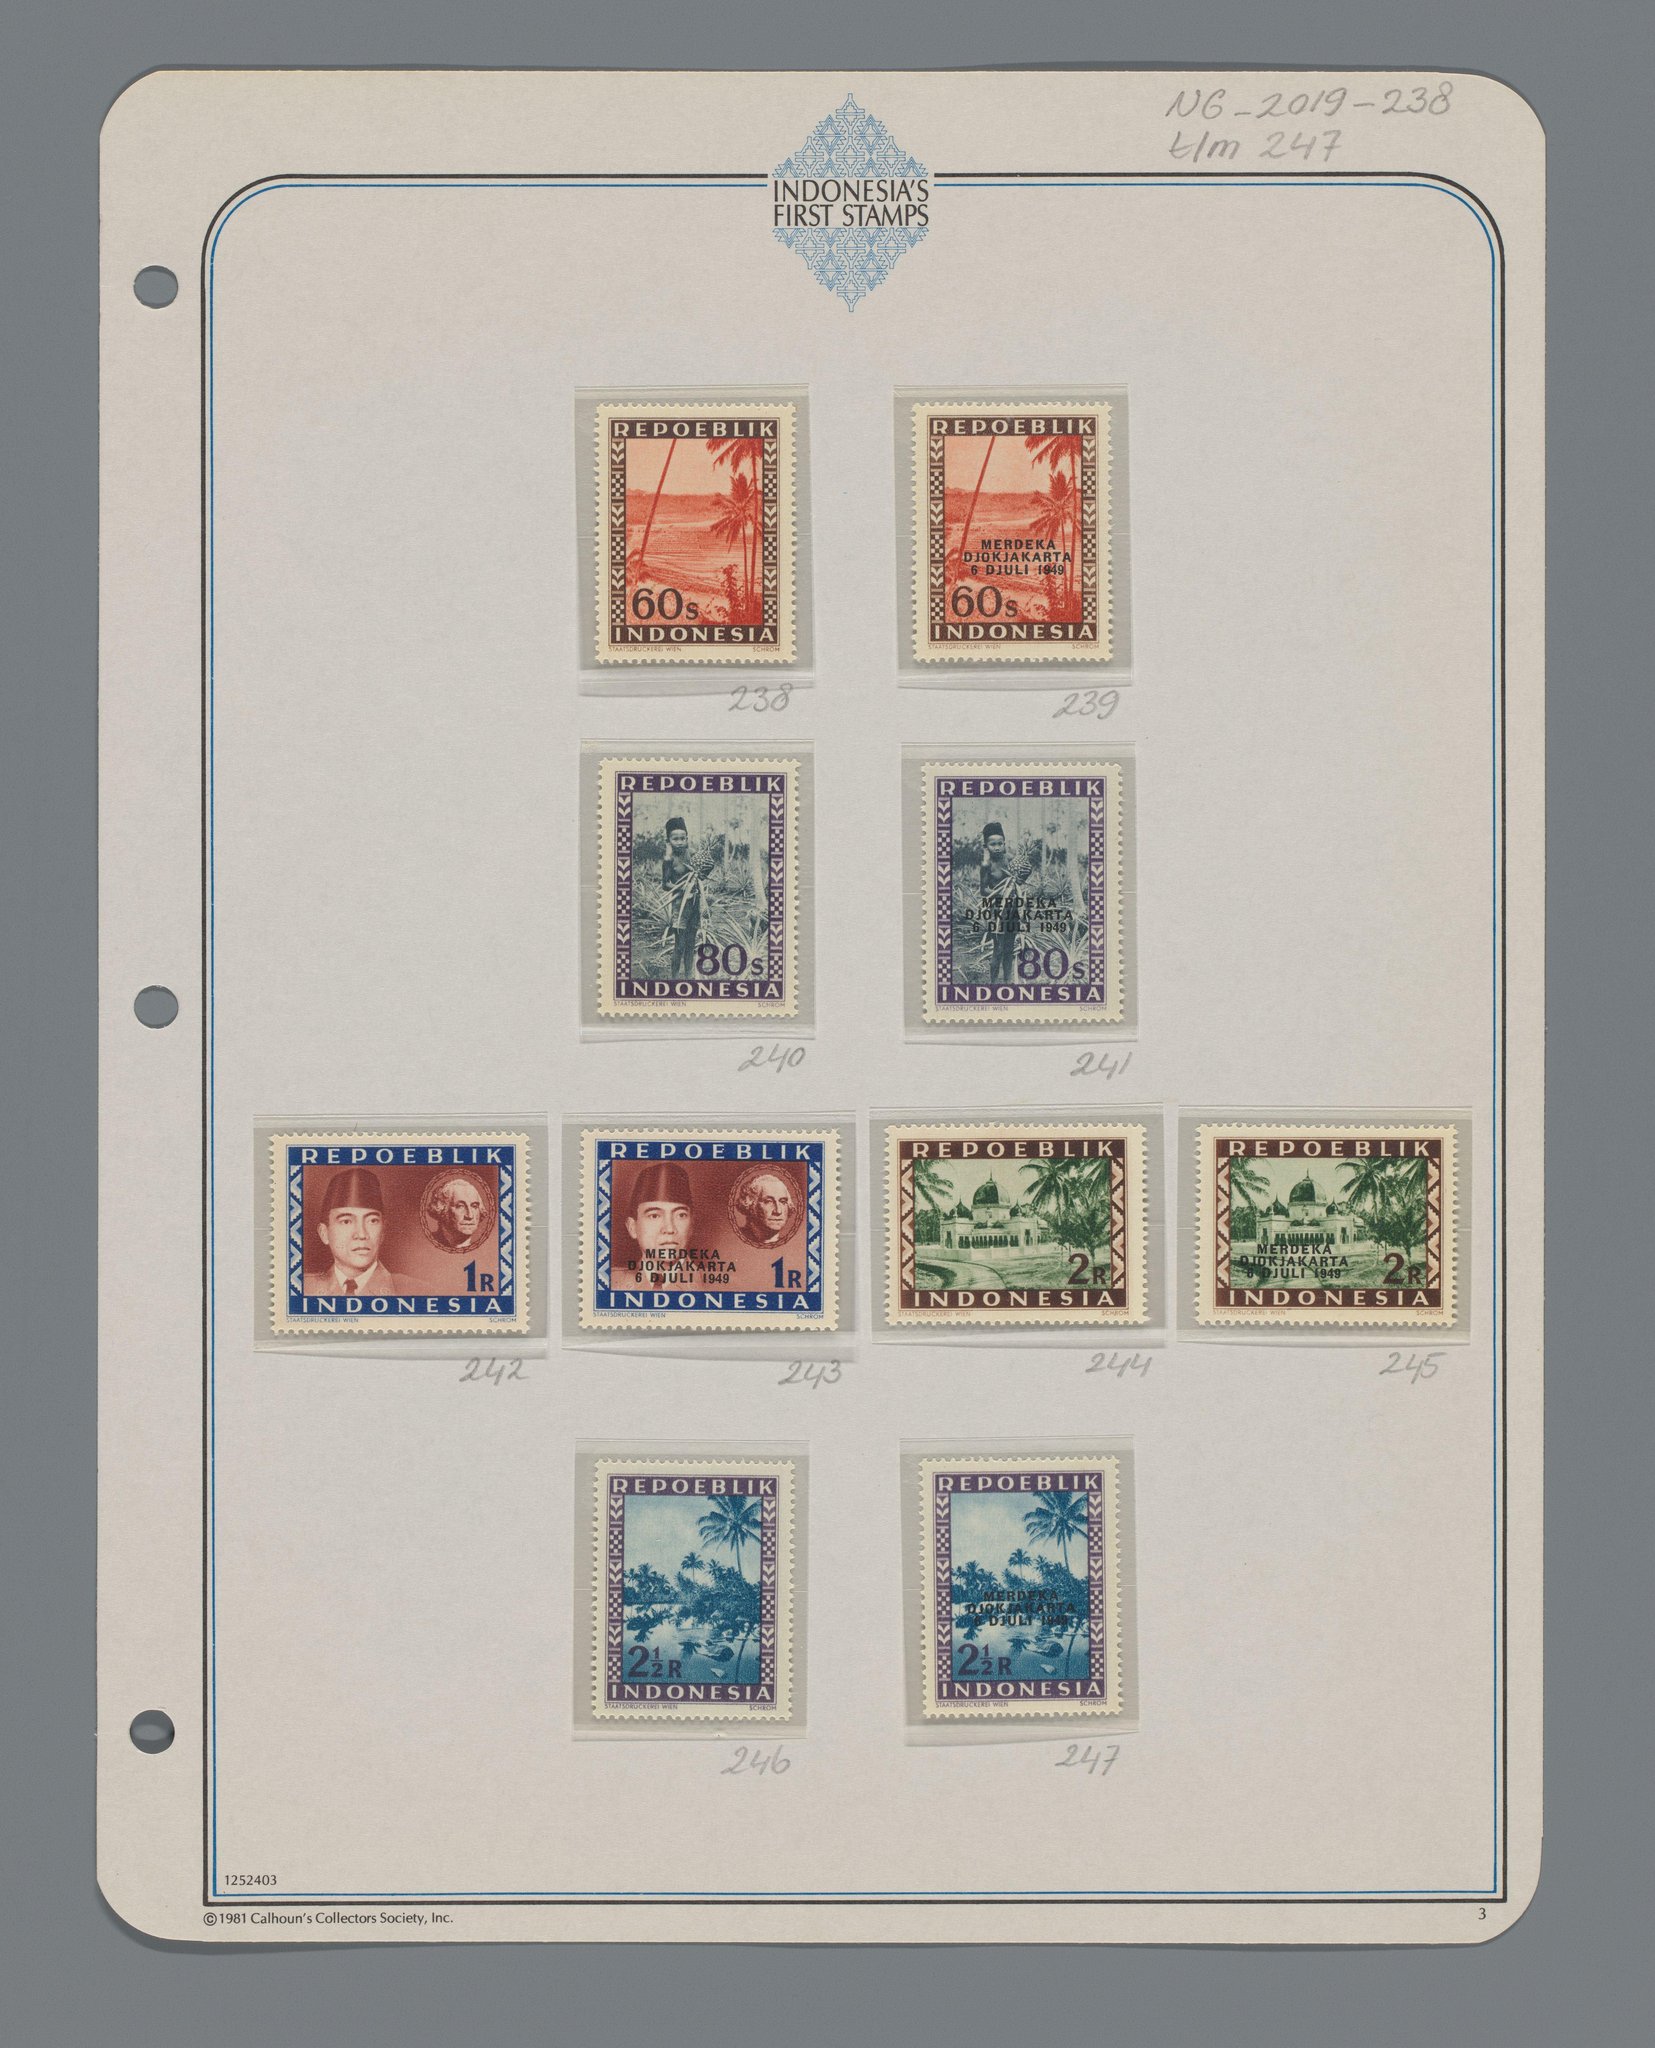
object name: postage stamp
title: Postzegel Republik Indonesia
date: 1949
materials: paper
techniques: photoaquatint, engraving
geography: philadelphia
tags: indonesia